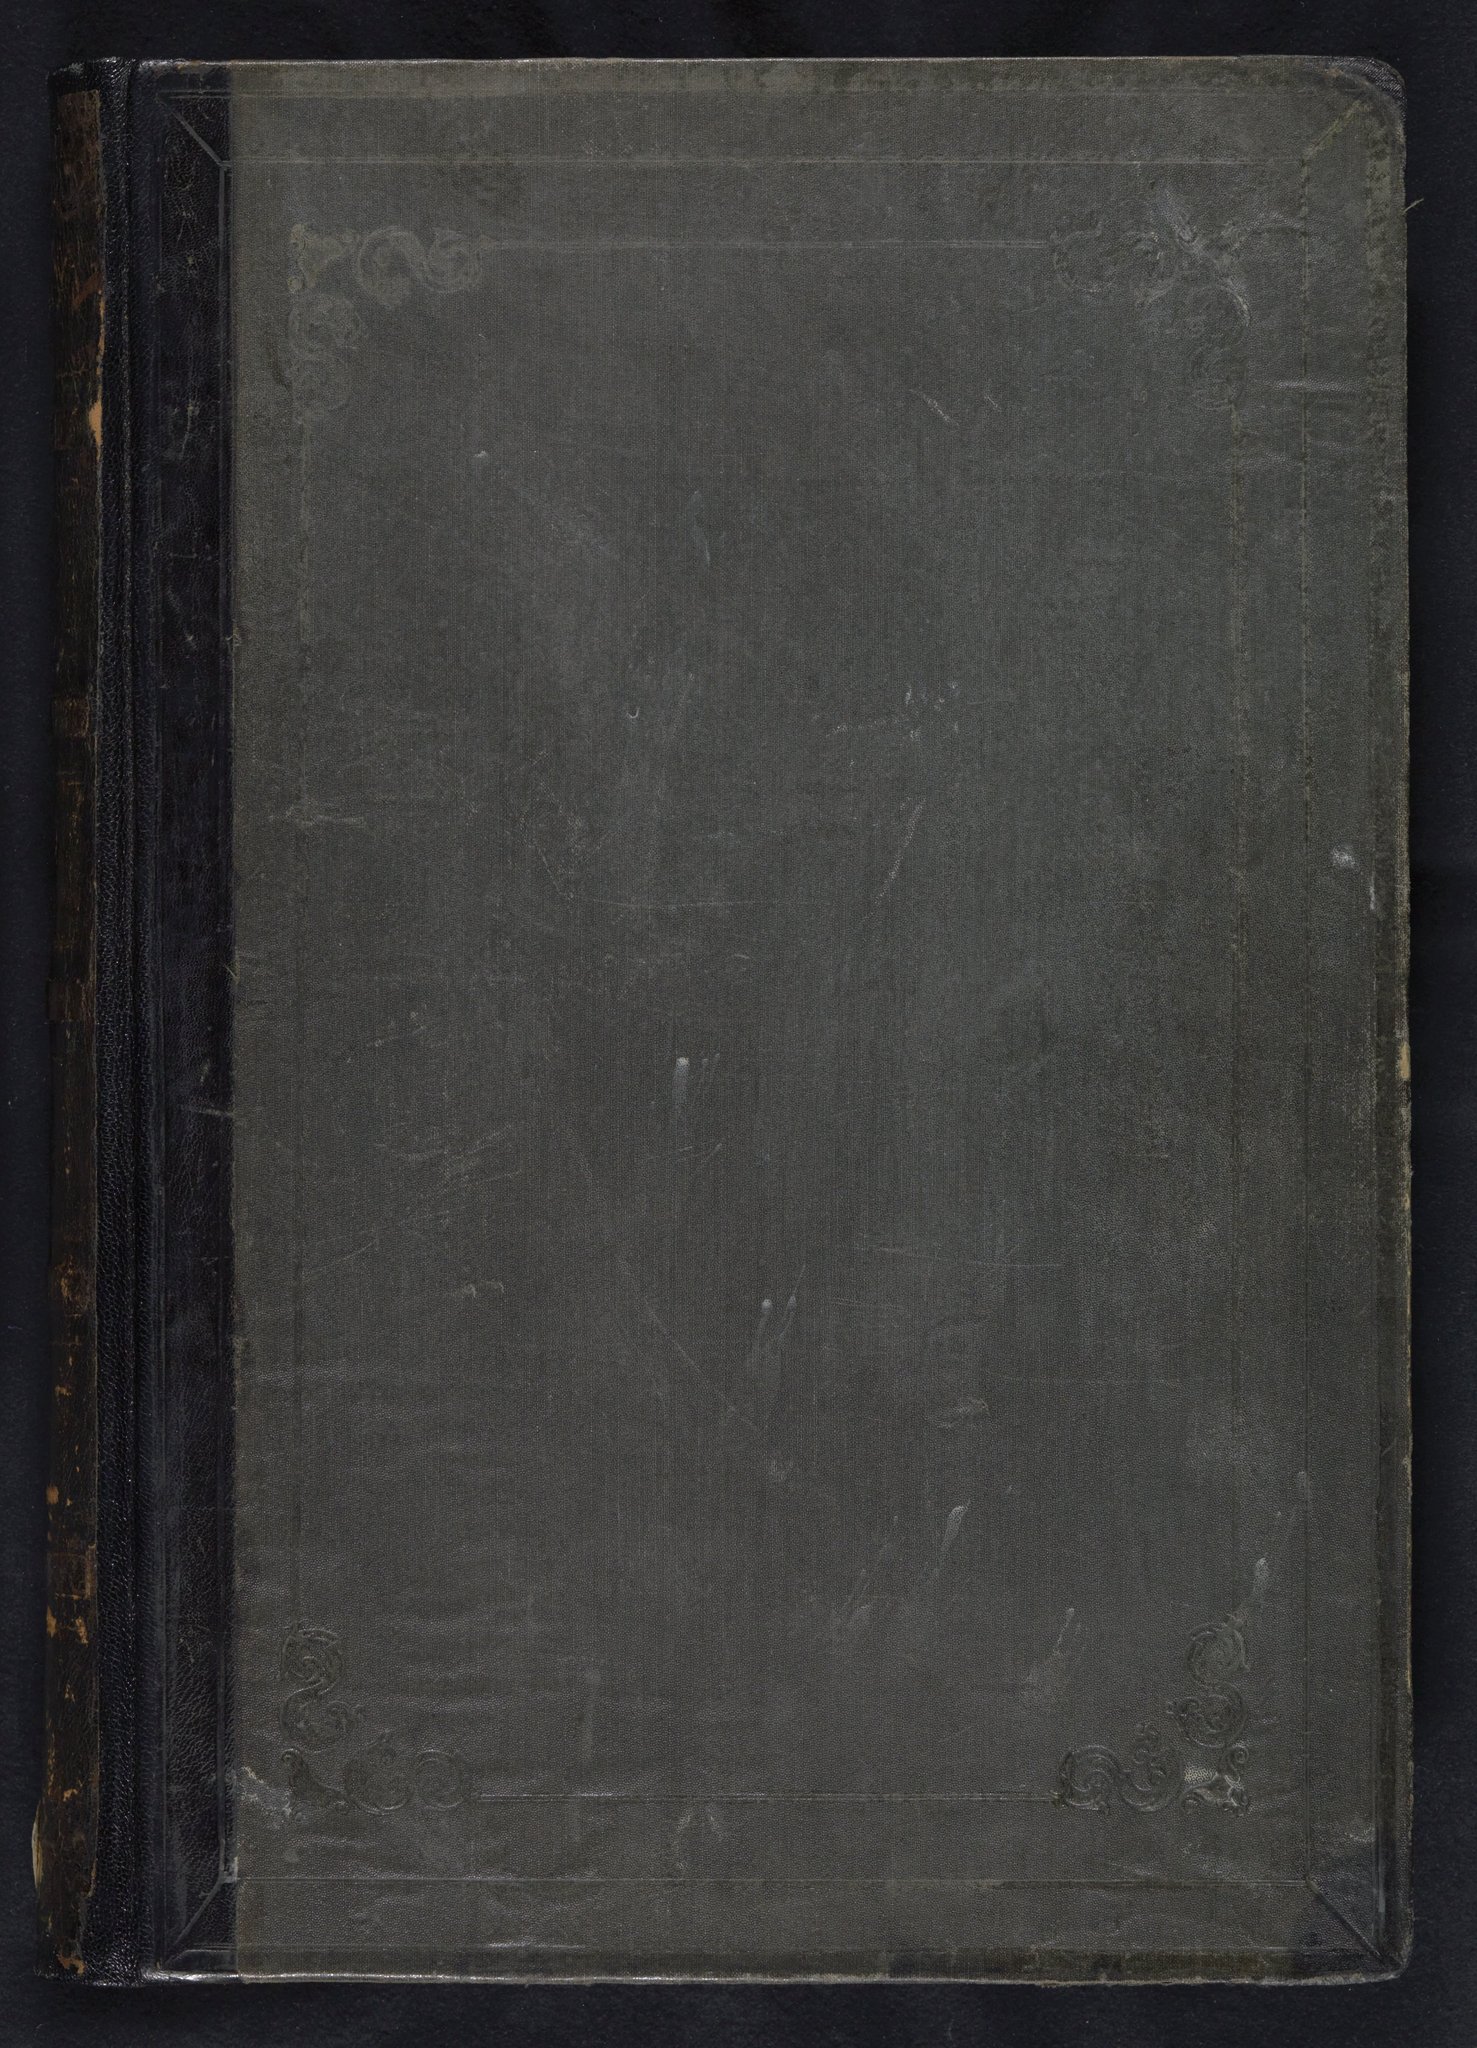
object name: photograph album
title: Album met foto’s van gipsafgietsels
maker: Anonymous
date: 1875-1900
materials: leather, paper, photographic support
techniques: albumen print, bookbinding, printing, marbling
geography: roermond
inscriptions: collector's mark: Lugt 2166, collector's mark: ‘[...]’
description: BI-B0699-137 bevat geen foto en is om die reden niet opgenomen.